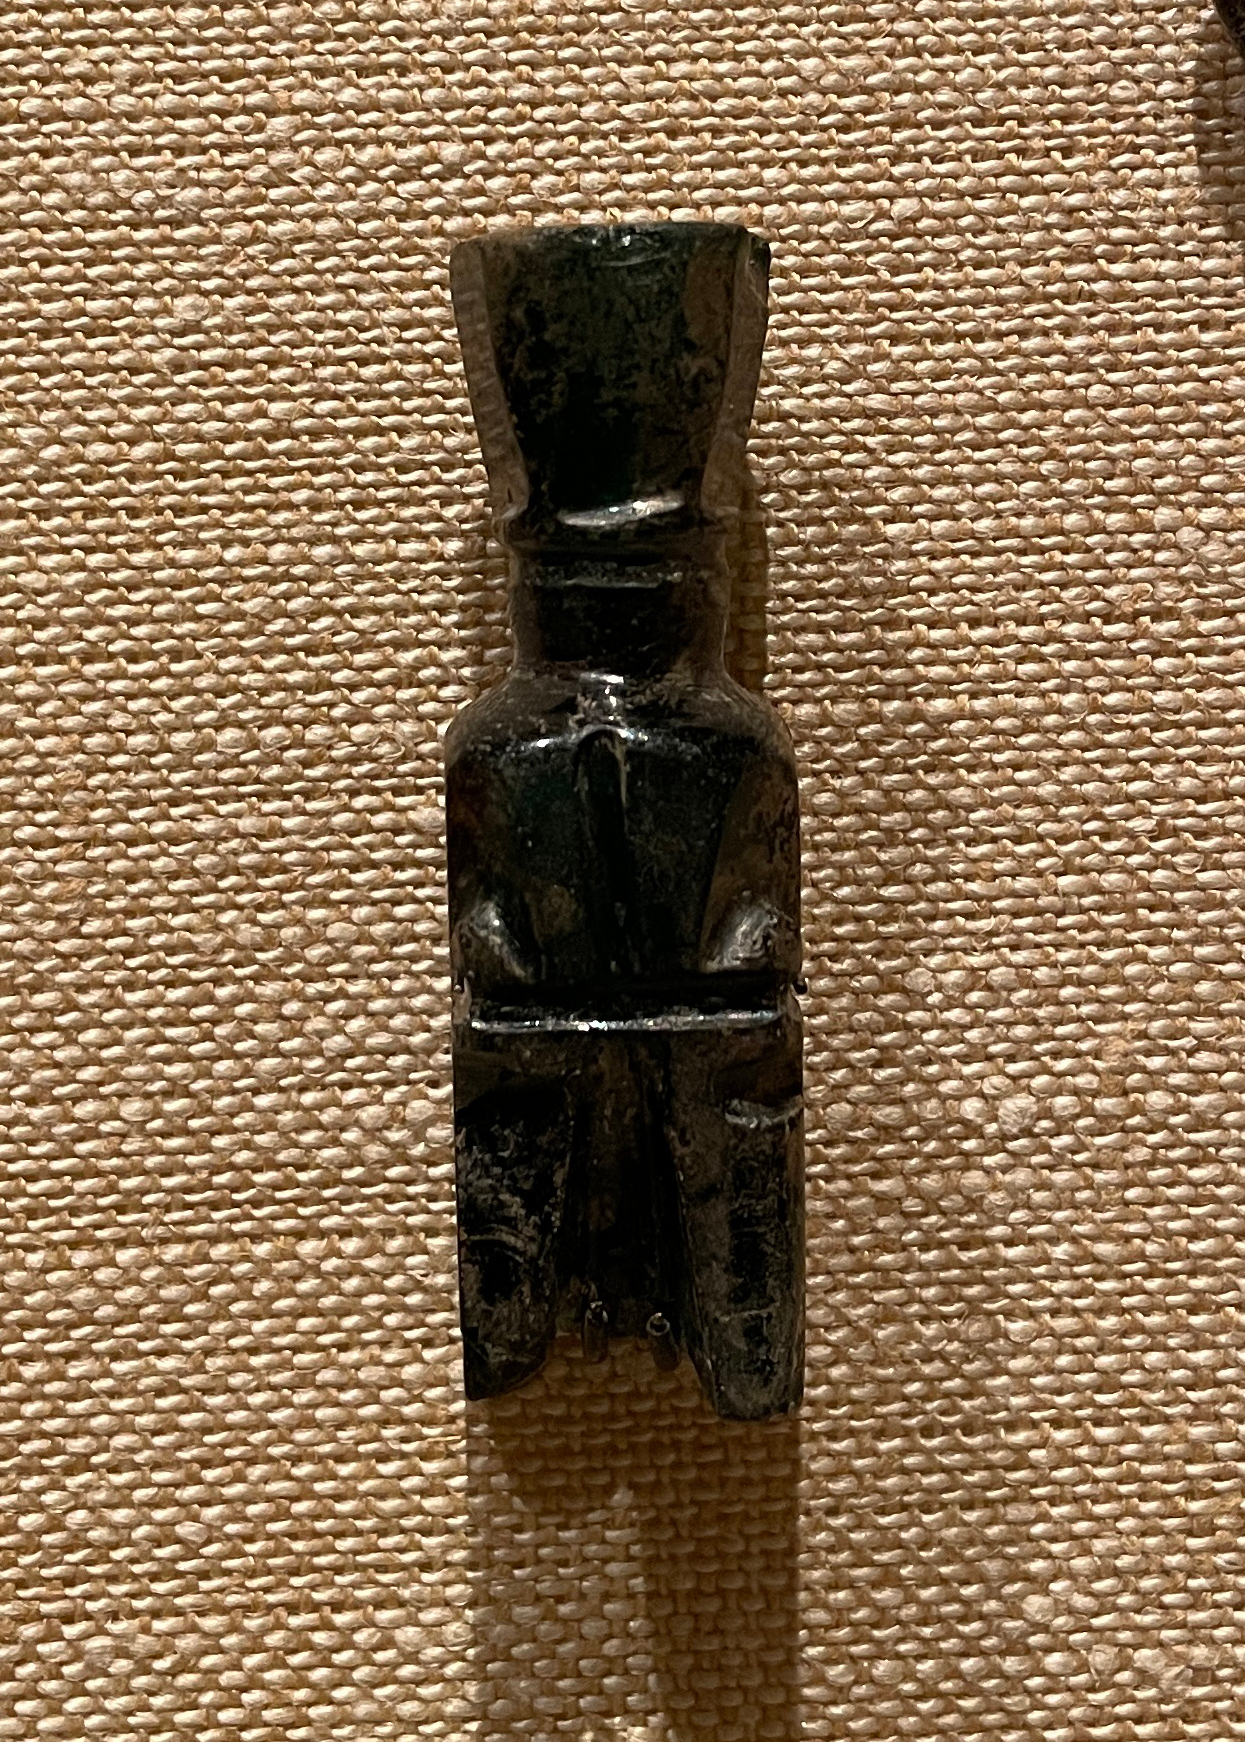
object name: bottle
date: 801-900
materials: glass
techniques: cutting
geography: iran